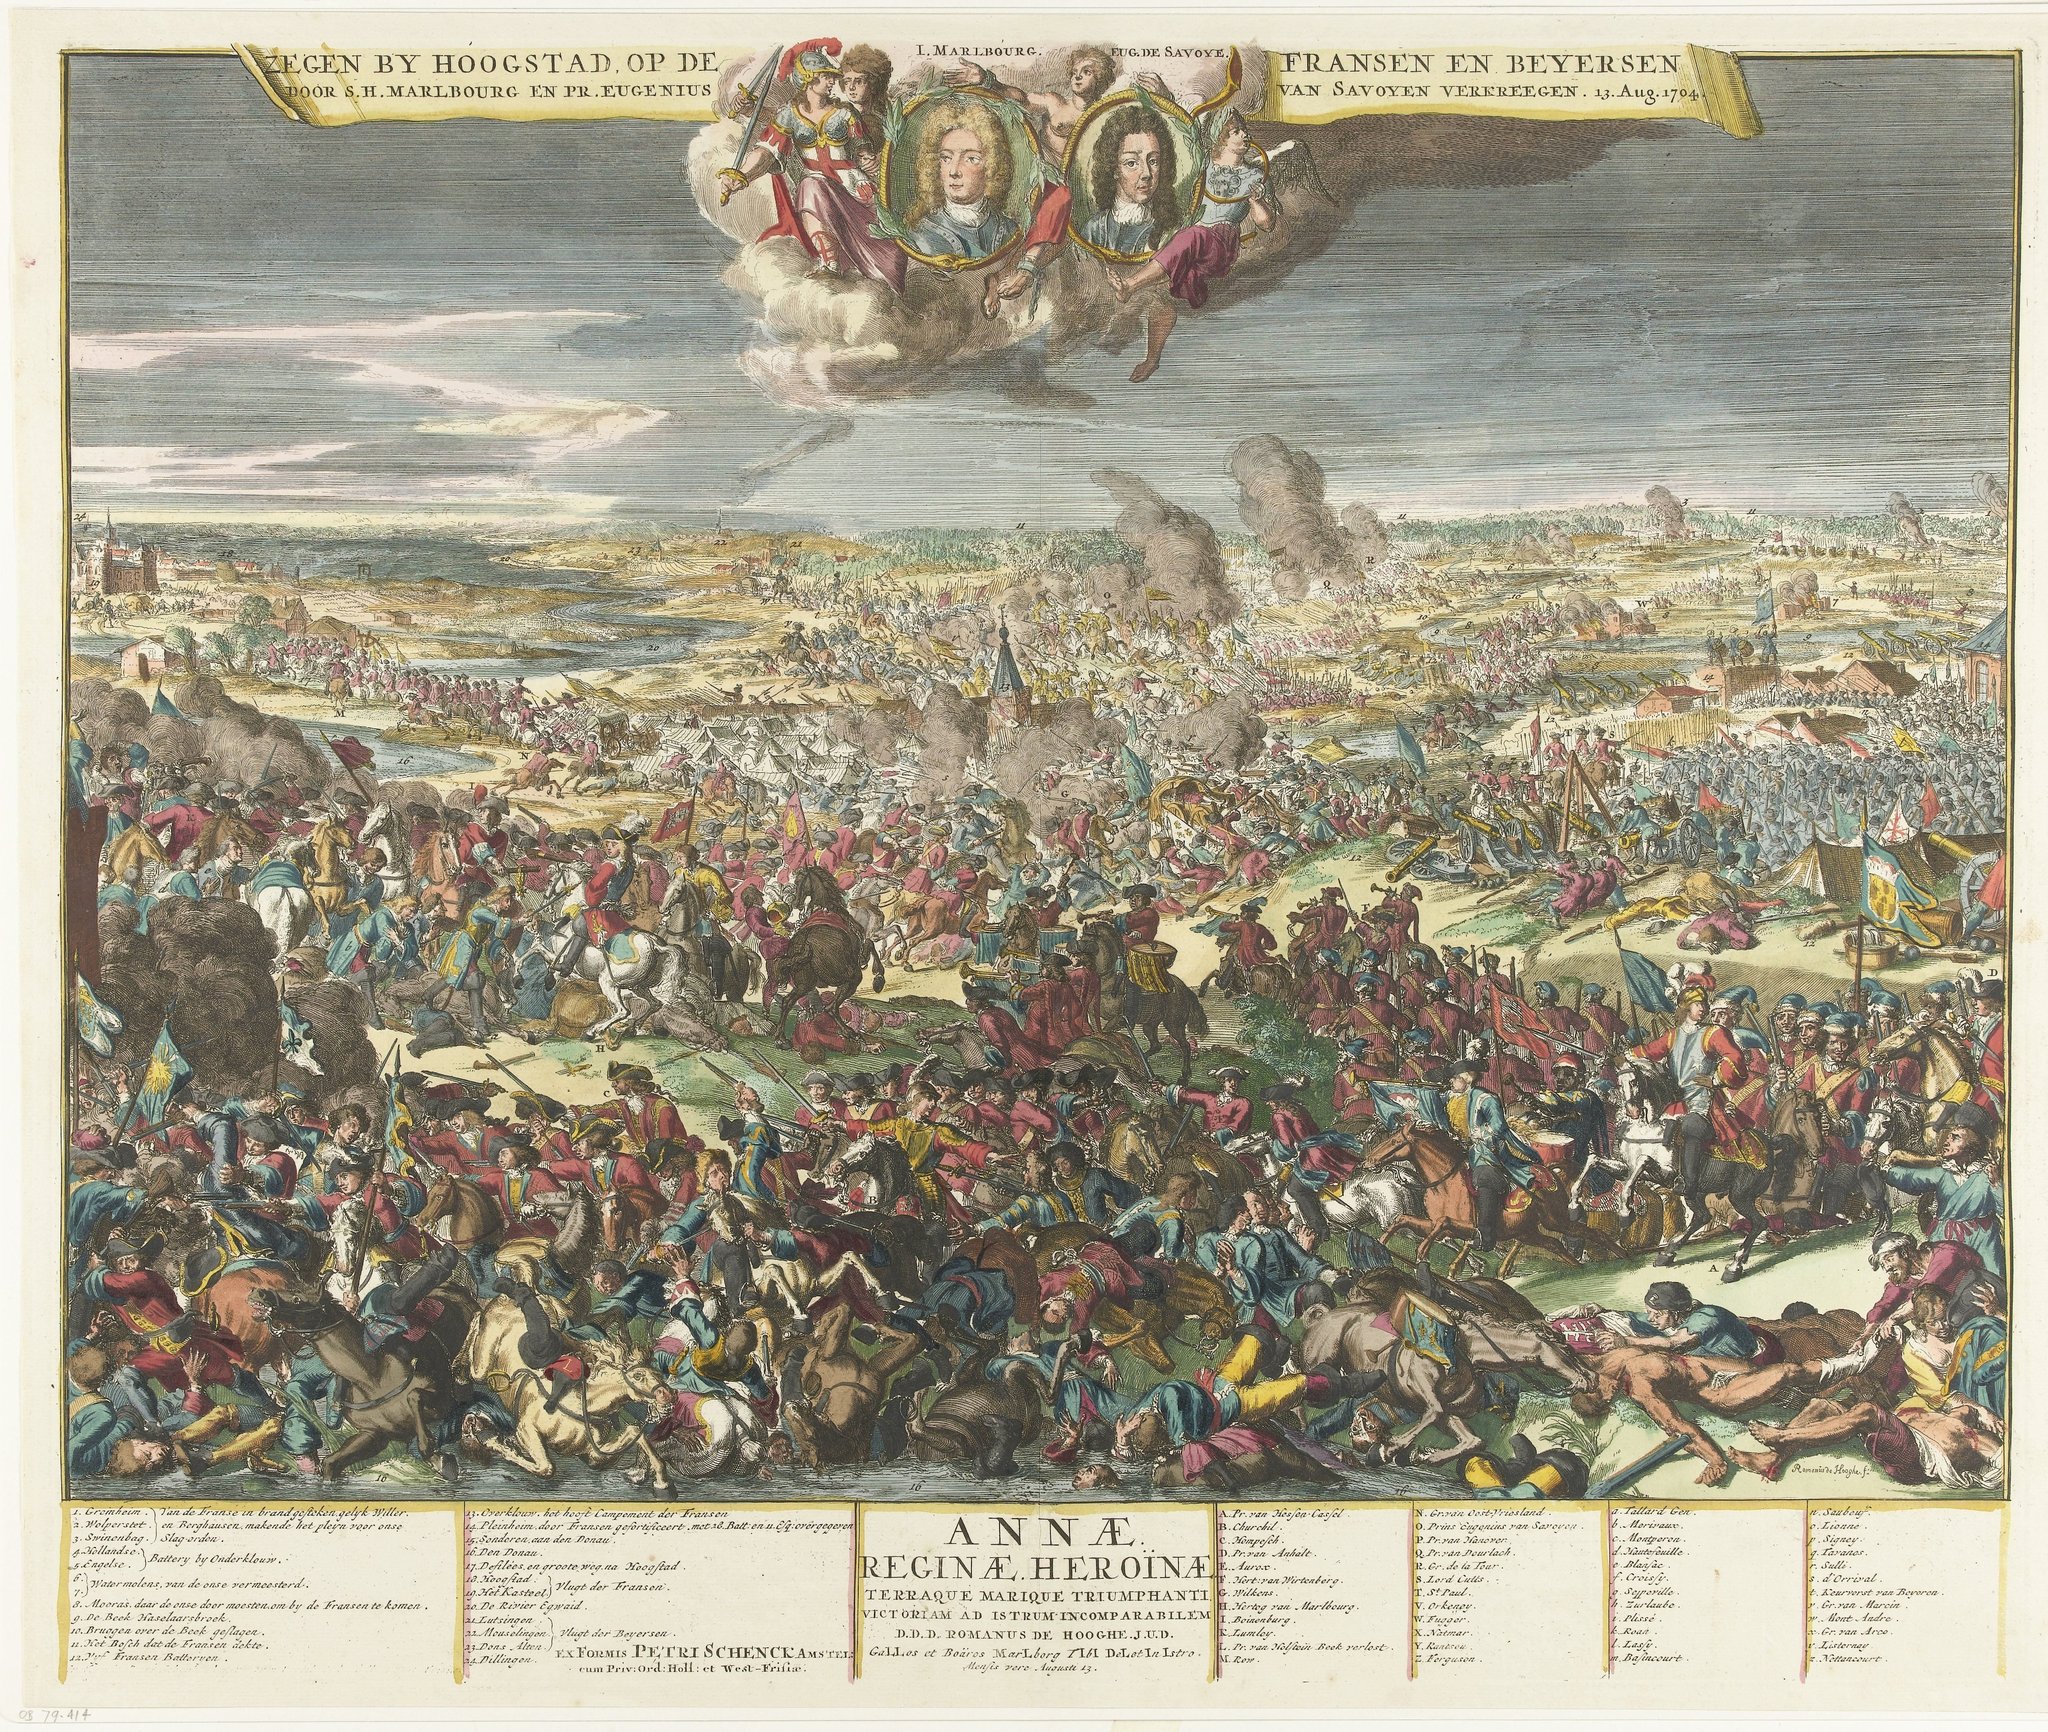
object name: print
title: Zegen by Hoogstad, op de Fransen en Beyersen door S.H. Marlbourg en Pr. Eugenius van Savoyen verkreegen, 13. Aug. 1704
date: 1704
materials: paper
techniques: etching, hand coloring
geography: northern netherlands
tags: paris, vienna, eugenius van savoye, john churchill (1e hertog van marlborough), battle (+ land forces)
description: Slag bij Höchstädt, bij Blenheim, in Beieren op 13 augustus 1704. Overwinning van de geallieerde troepen onder de hertog van Marlborough en de prins van Savoye (wier portretten bovenaan de voorstelling staan) op de Franse en Beierse troepen. In het onderschrift de legenda's 1-24 en A-z.